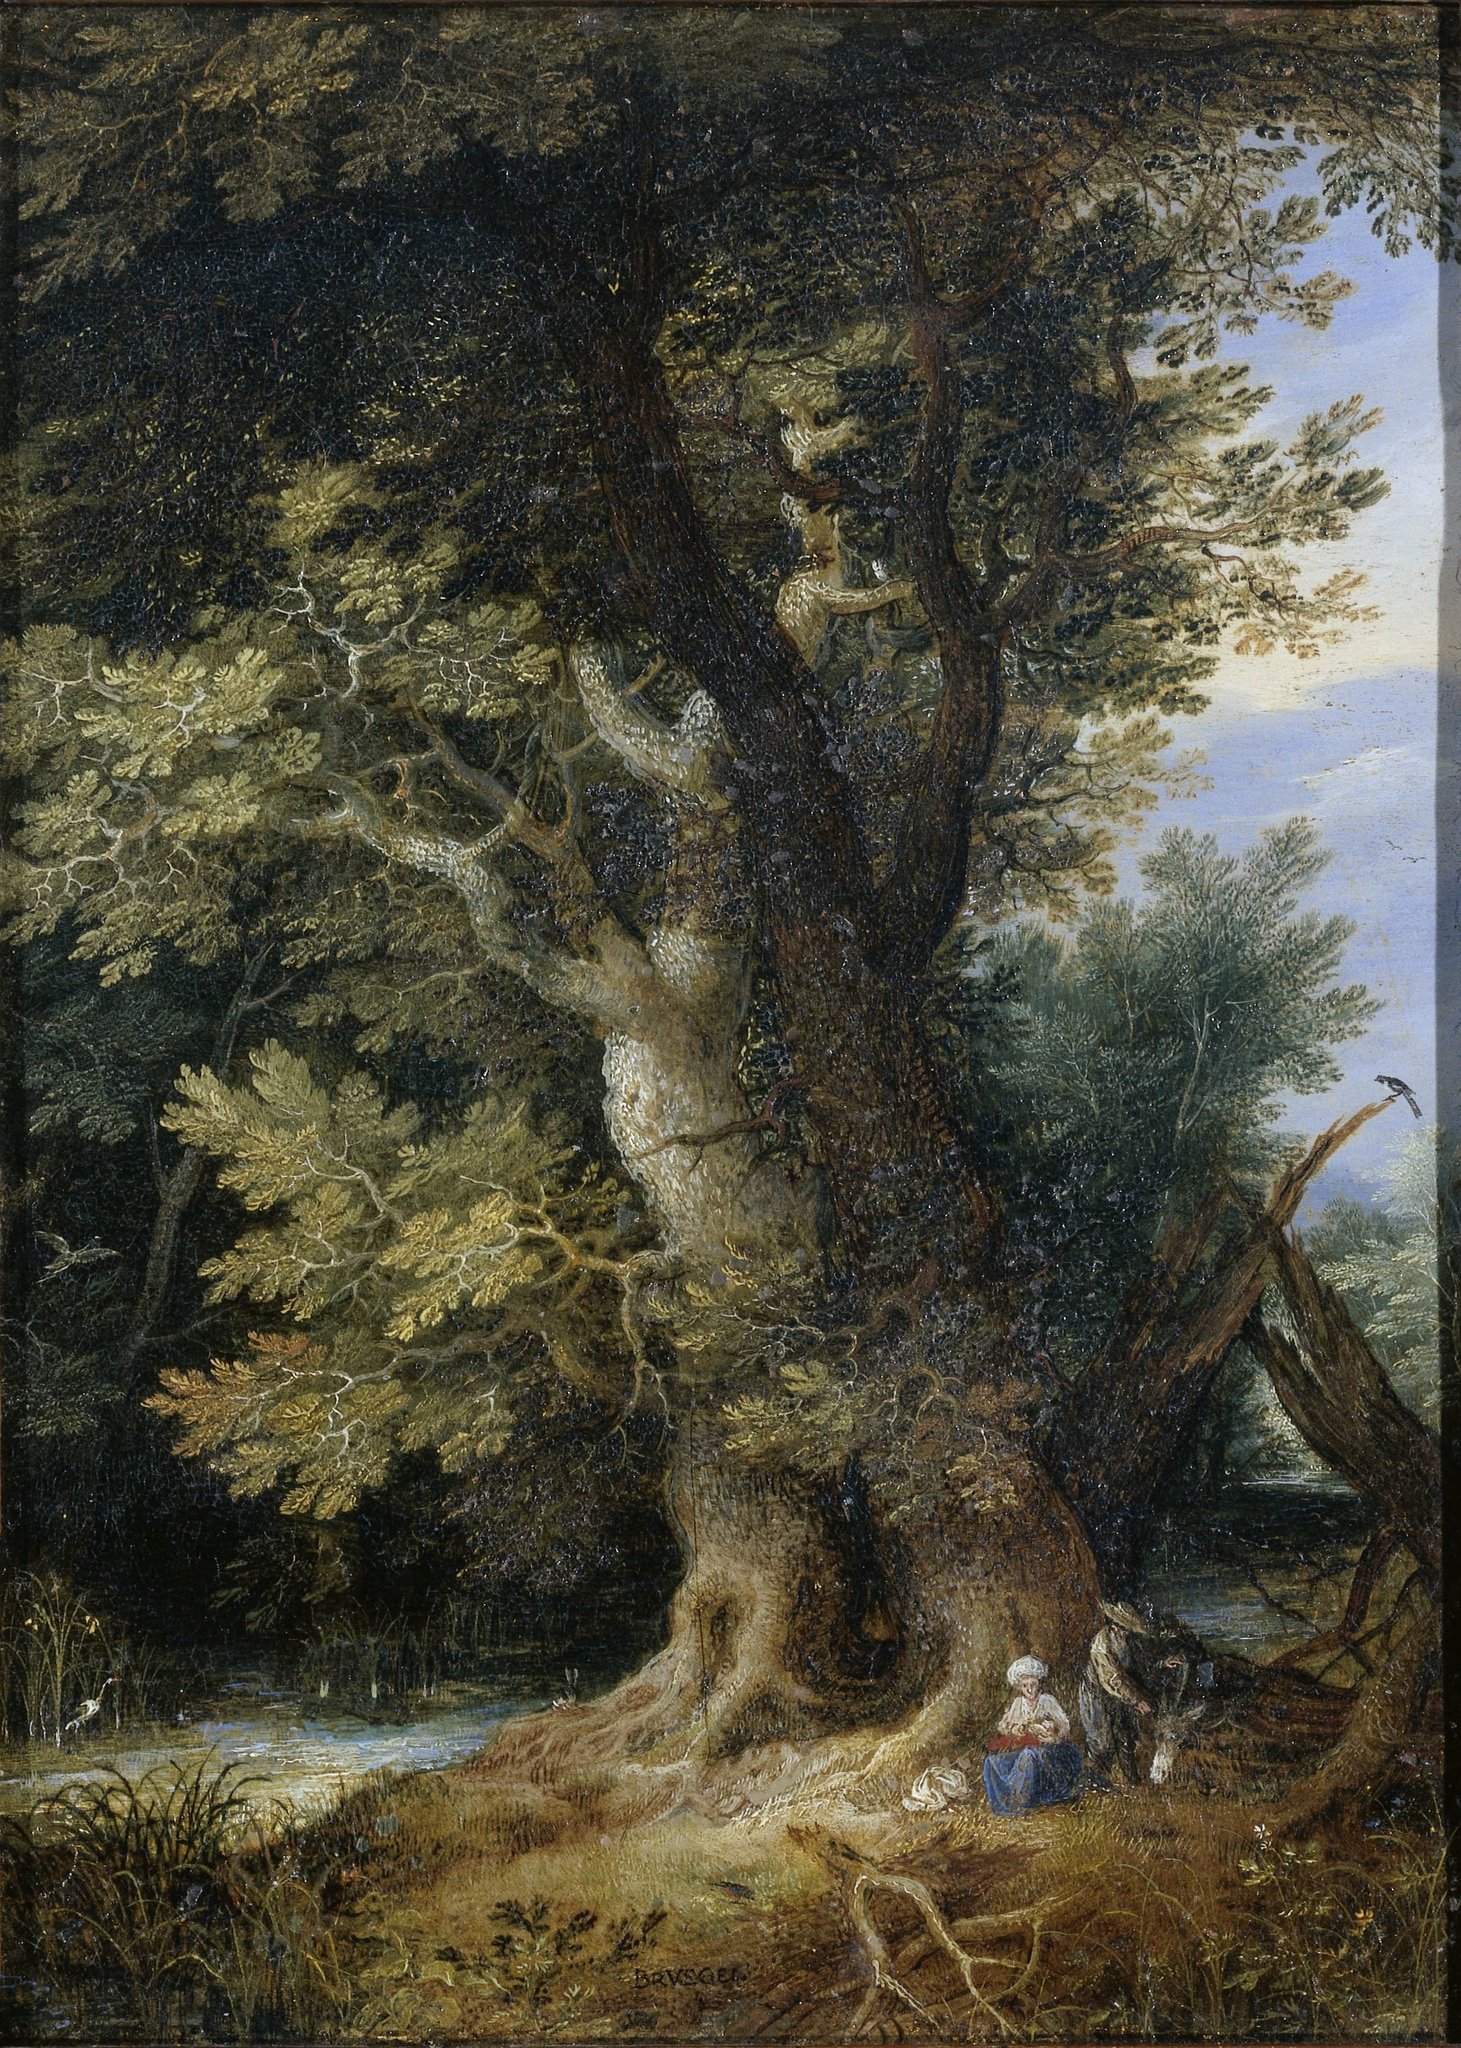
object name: painting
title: Rest on the Flight into Egypt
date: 1600-1699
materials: copper, oil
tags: trees, forest, wood, rest on the flight into egypt - bb - landscape predominant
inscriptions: signature (false): ‘Brvegel’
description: Rust op de vlucht naar Egypte. De Heilige Familie rust aan de voet van twee grote bomen.